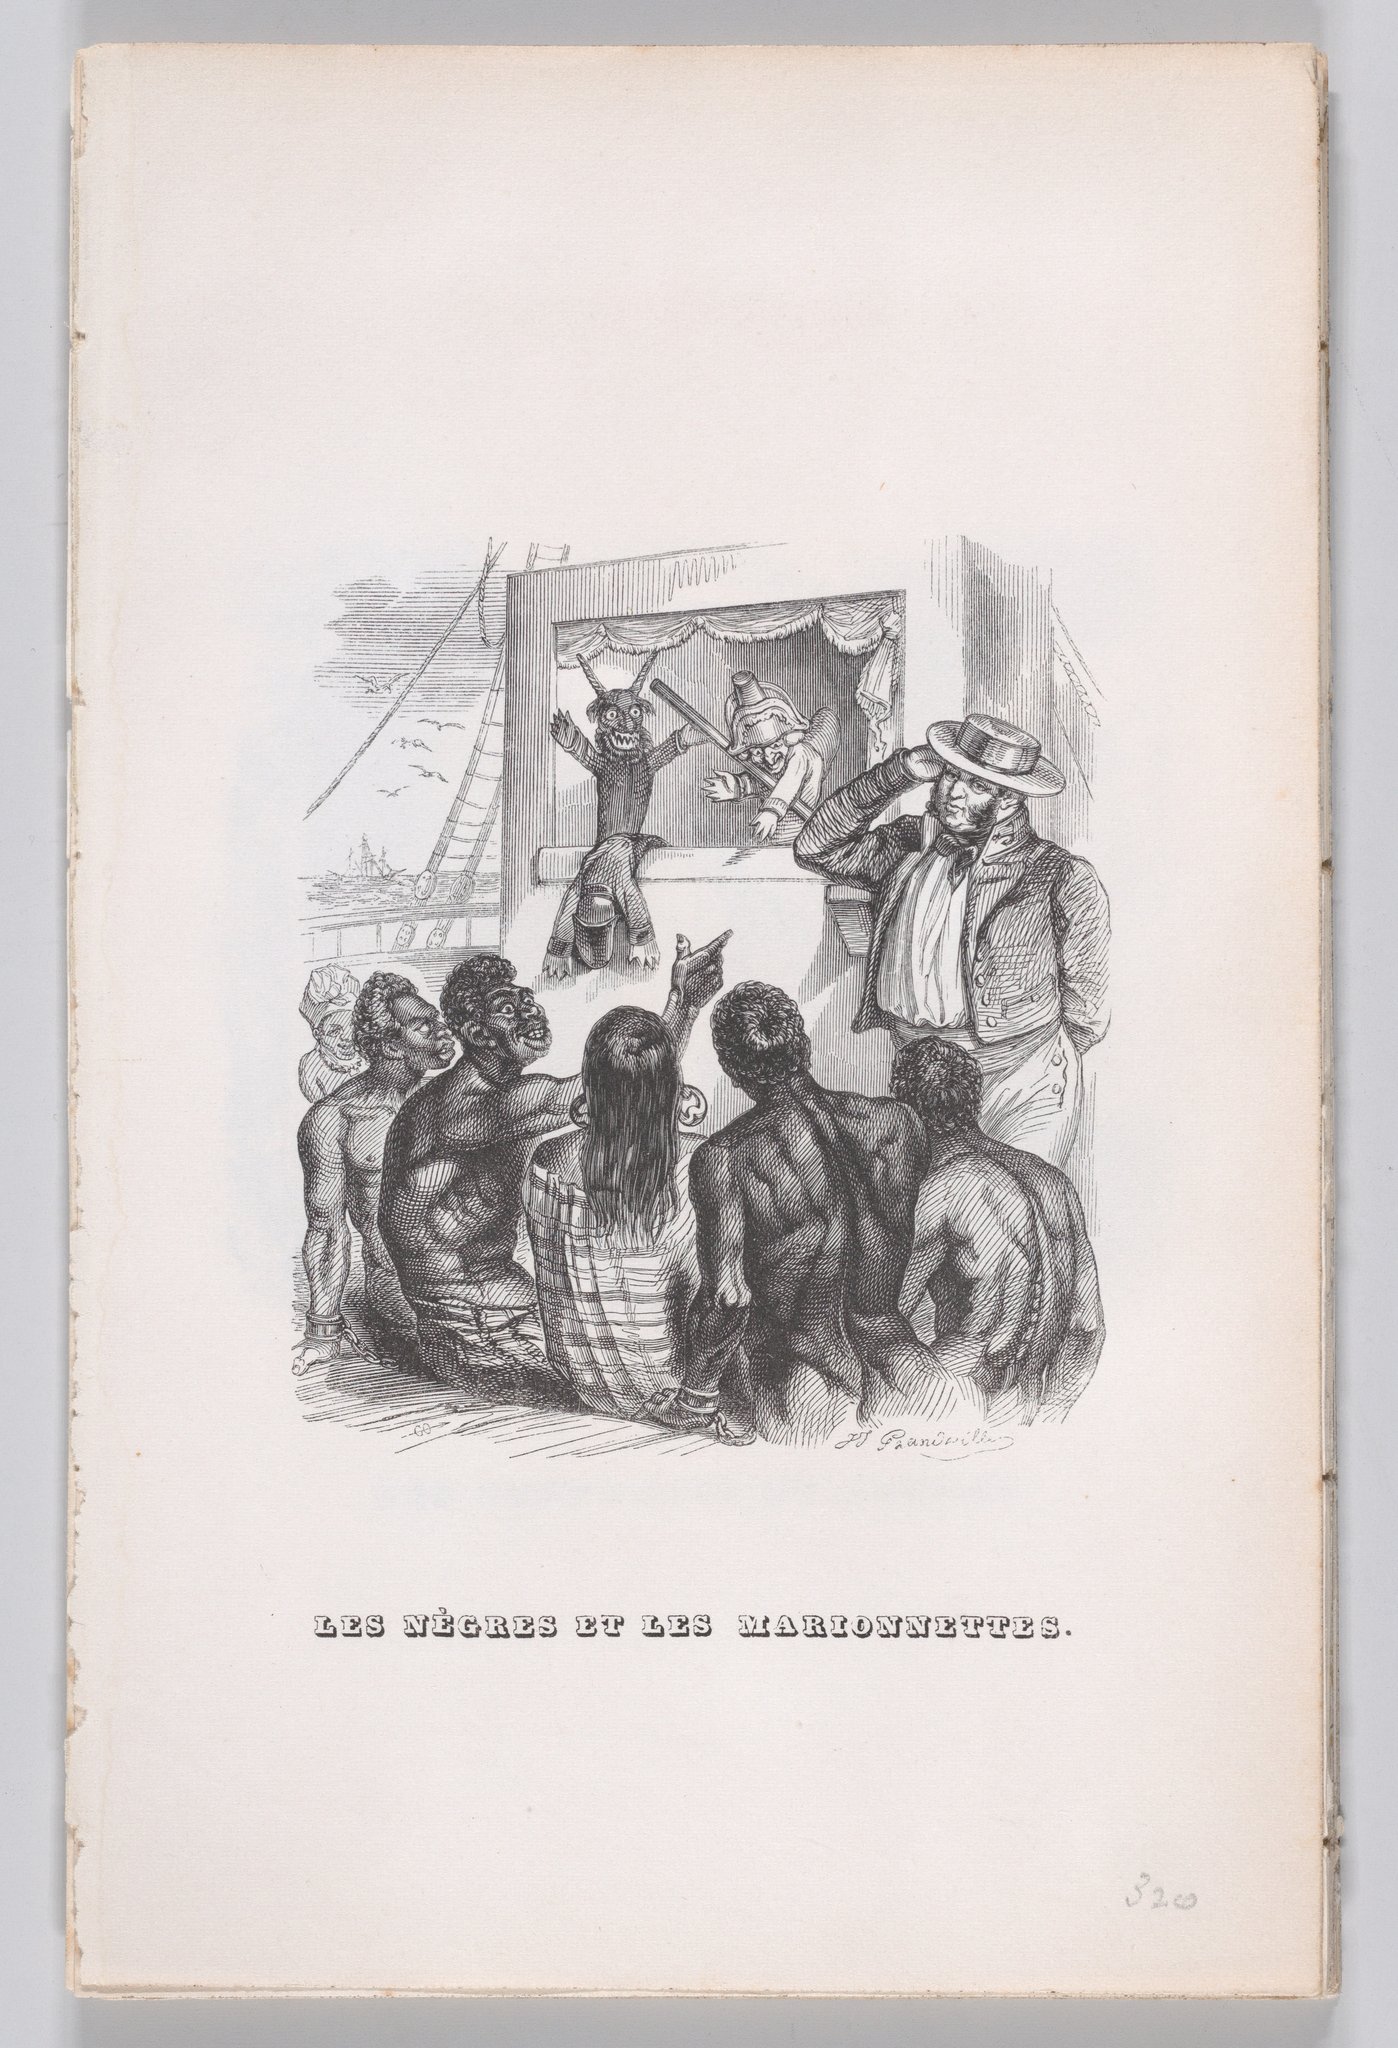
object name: print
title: The Negroes and the Puppets, from "The Complete Works of Béranger"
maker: j. j. grandville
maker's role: artist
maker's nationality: french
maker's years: 1803-1847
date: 1836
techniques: engraving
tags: men,puppets